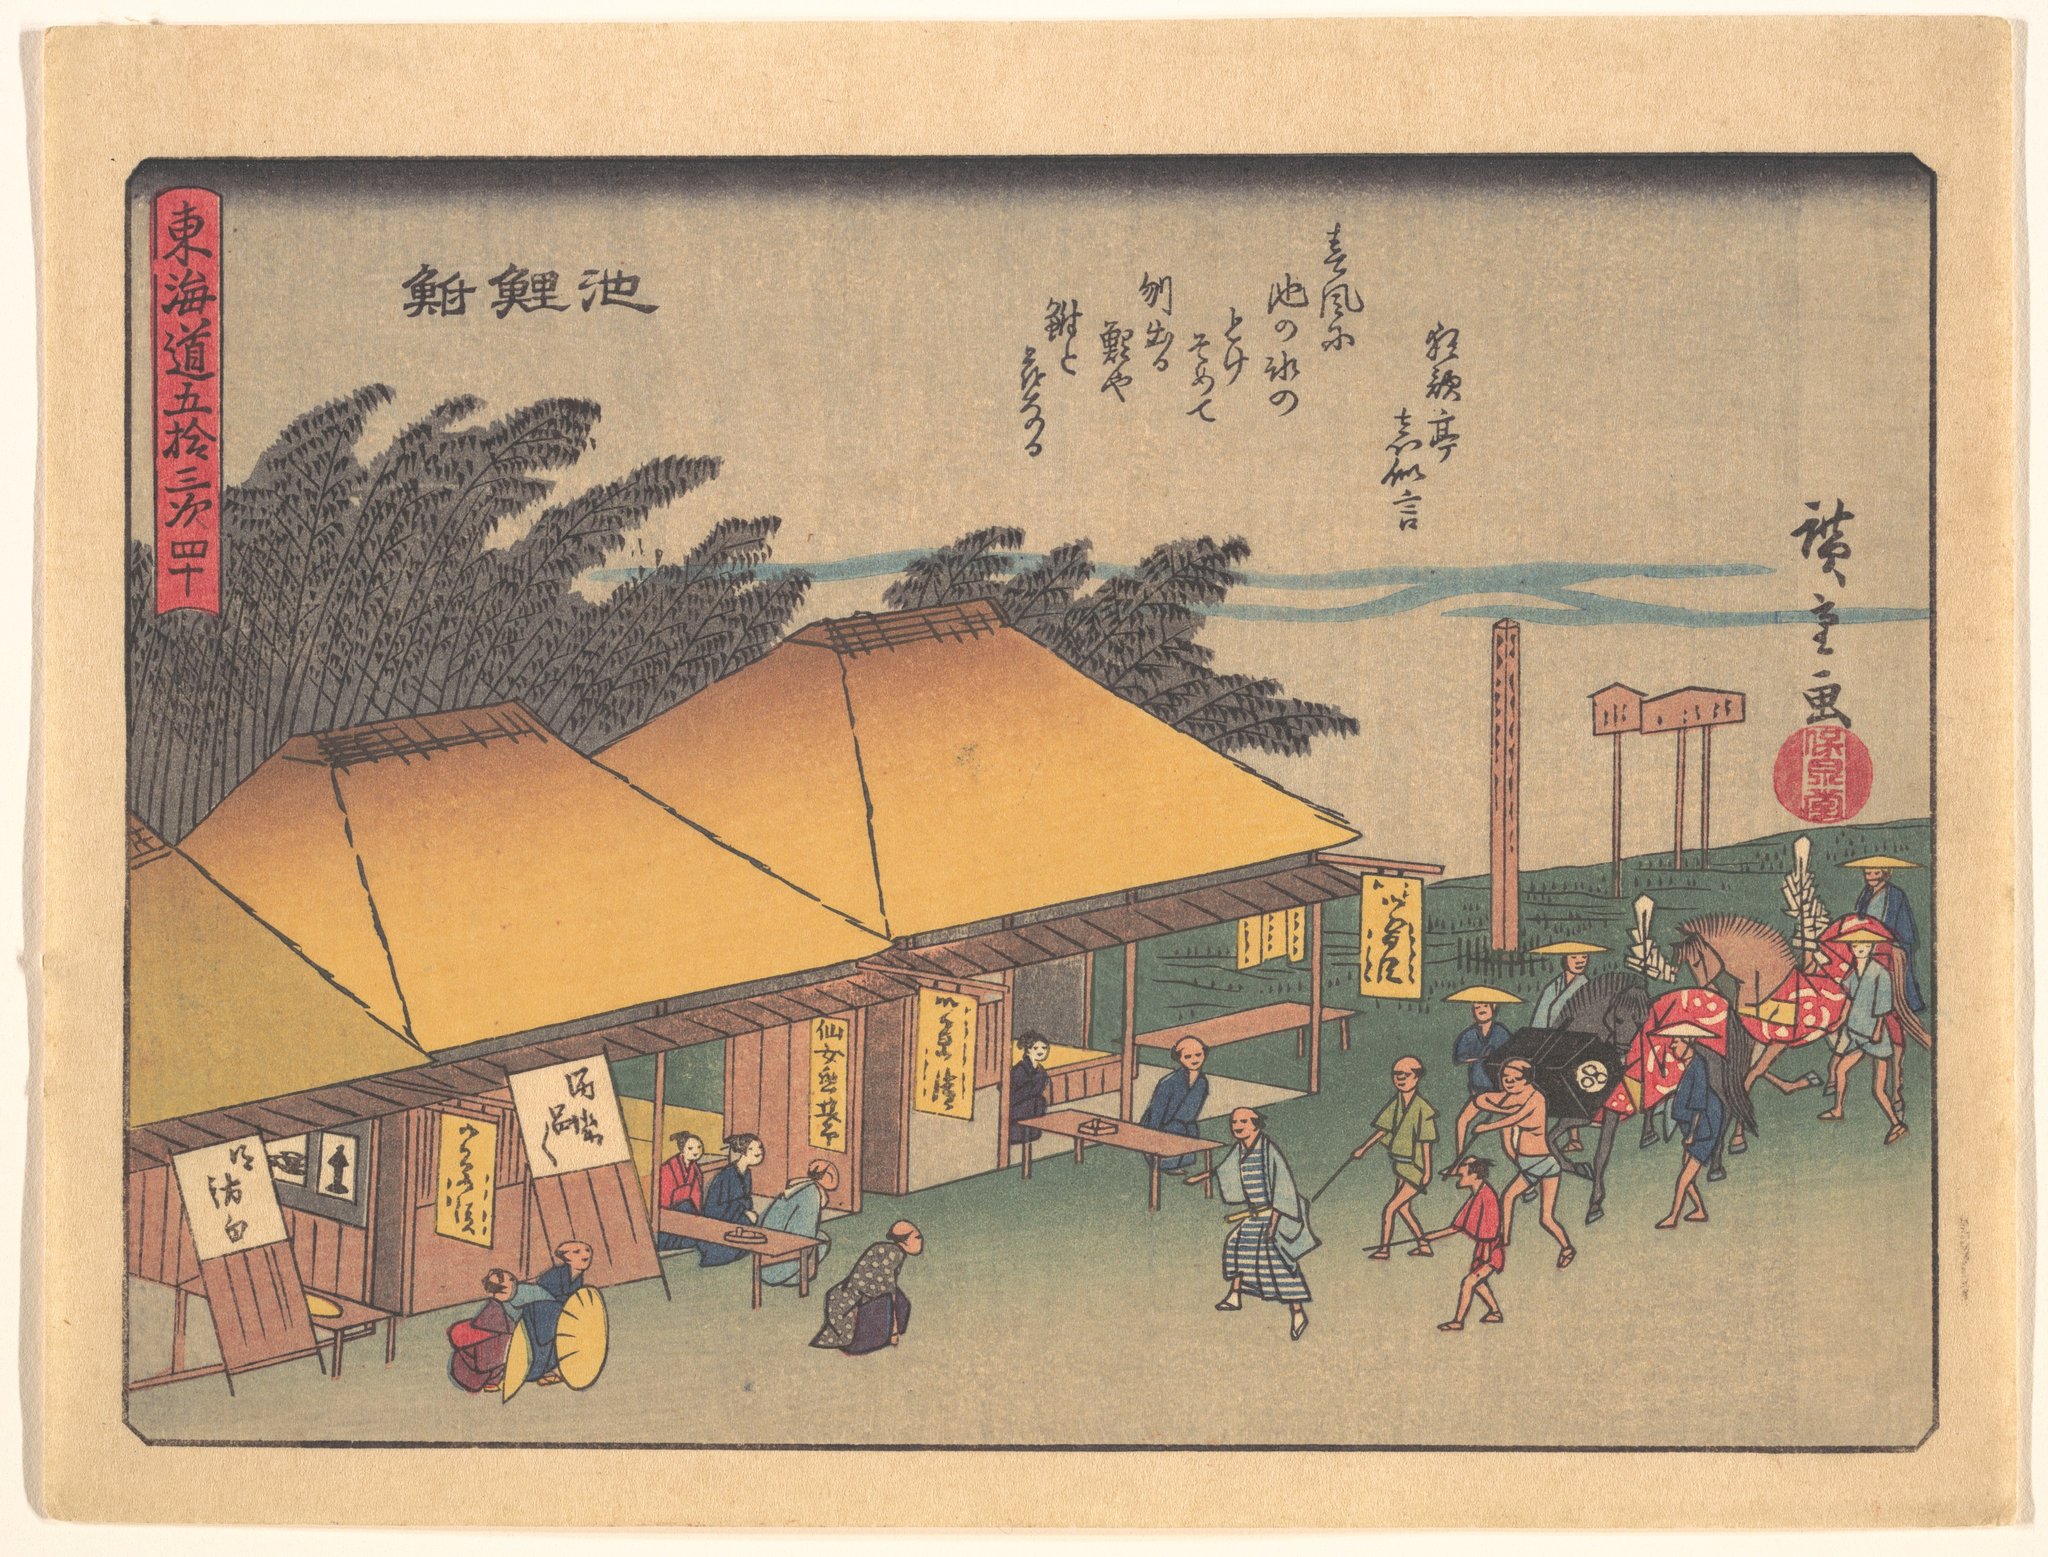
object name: print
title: Chiryūshuku, from the series The Fifty-three Stations of the Tōkaidō Road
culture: japanese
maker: utagawa hiroshige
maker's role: artist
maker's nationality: japanese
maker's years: 1797-1858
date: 1901-1933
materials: ink, paper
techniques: woodblock print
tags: human figures,roads,horses,trees